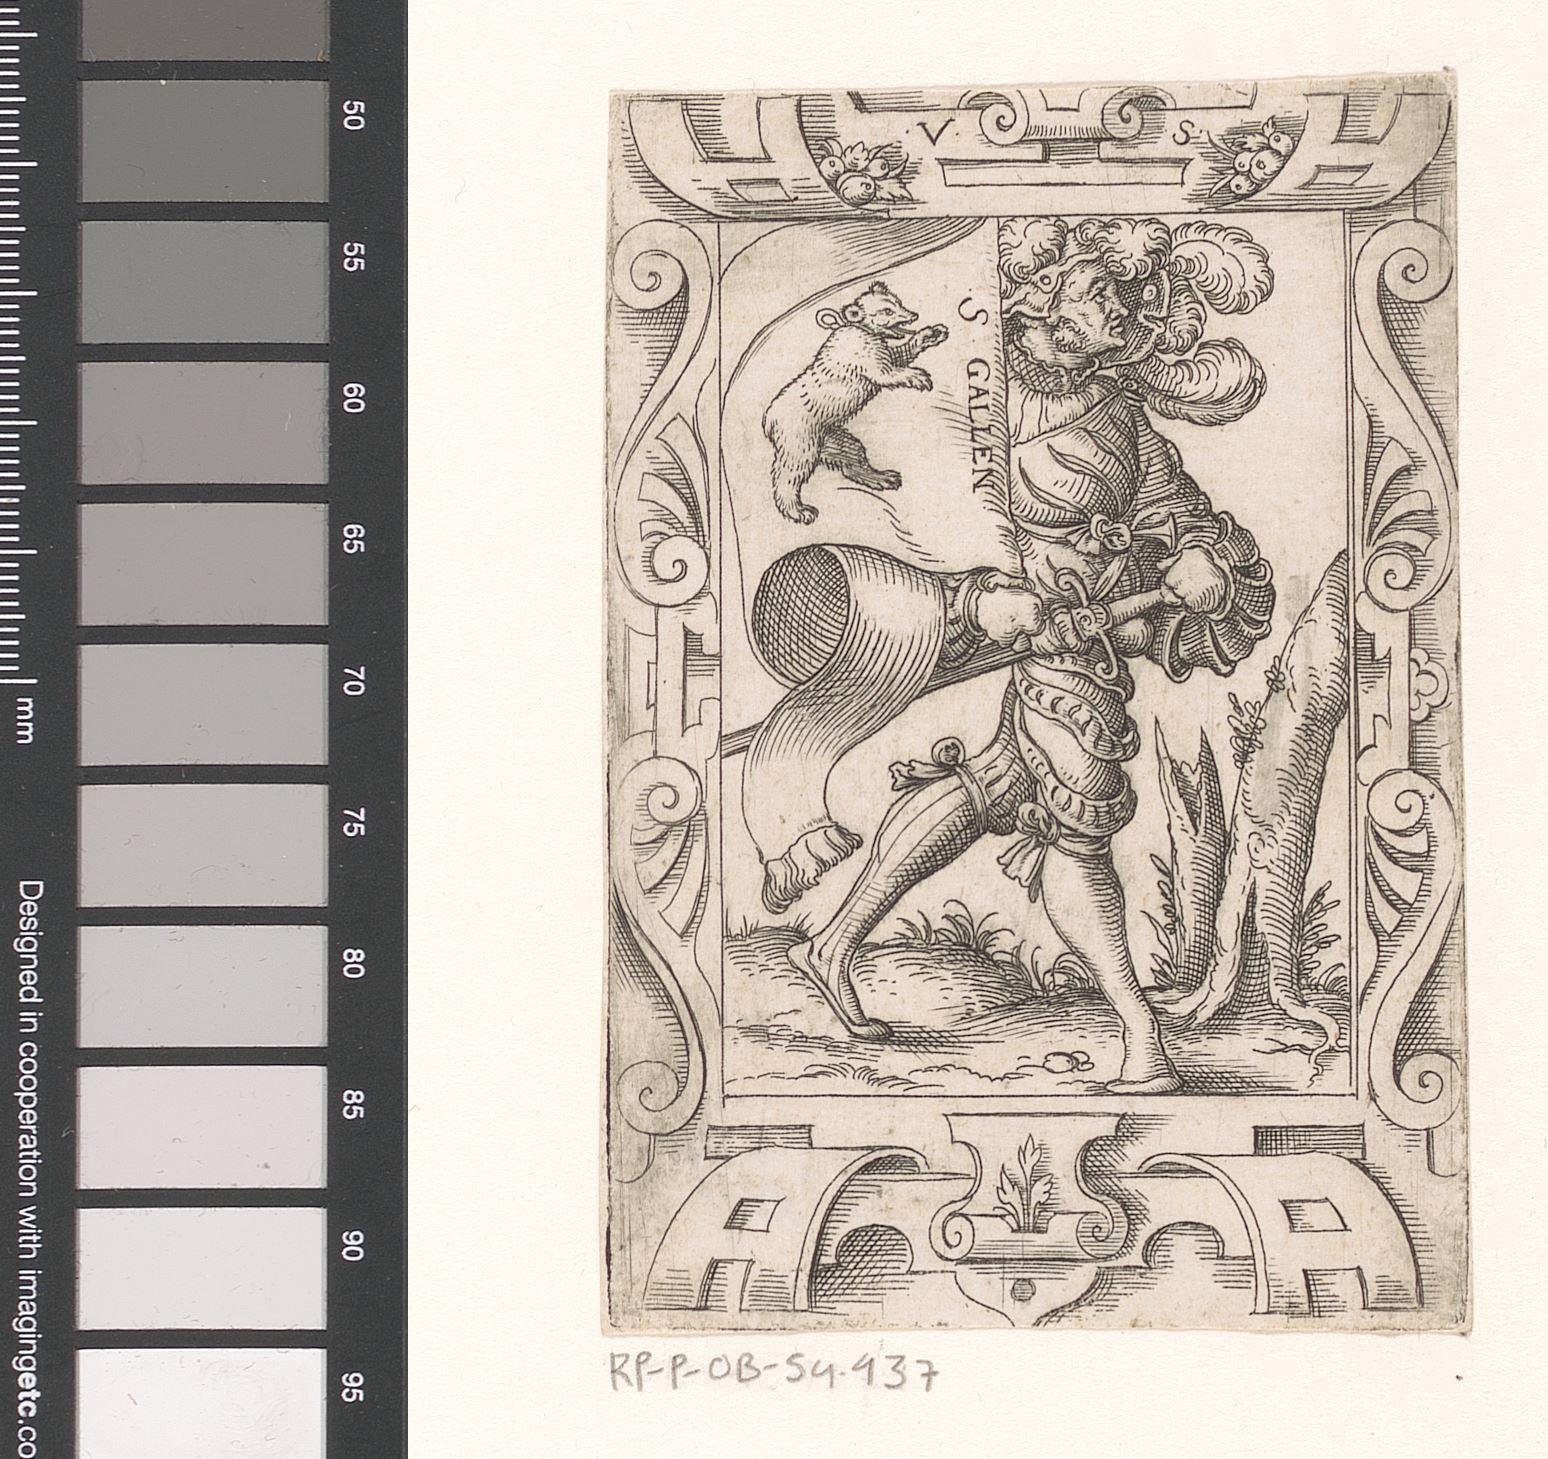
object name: print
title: S. Gallen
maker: virgilius solis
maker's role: draughtsman, print maker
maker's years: 1514-1562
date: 1524-1562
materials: paper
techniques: engraving, etching, intaglio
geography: nuremberg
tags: scrollwork, strapwork ~ ornament, (military) standard-bearer, the monk and hermit gall(us); possible attributes: bear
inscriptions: collector's mark: Lugt 2228, number: ‘145’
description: Prent maakt deel uit van een serie van veertien prenten met voorstellingen van vaandeldragers met vaandels van de Zwitserse kantons.